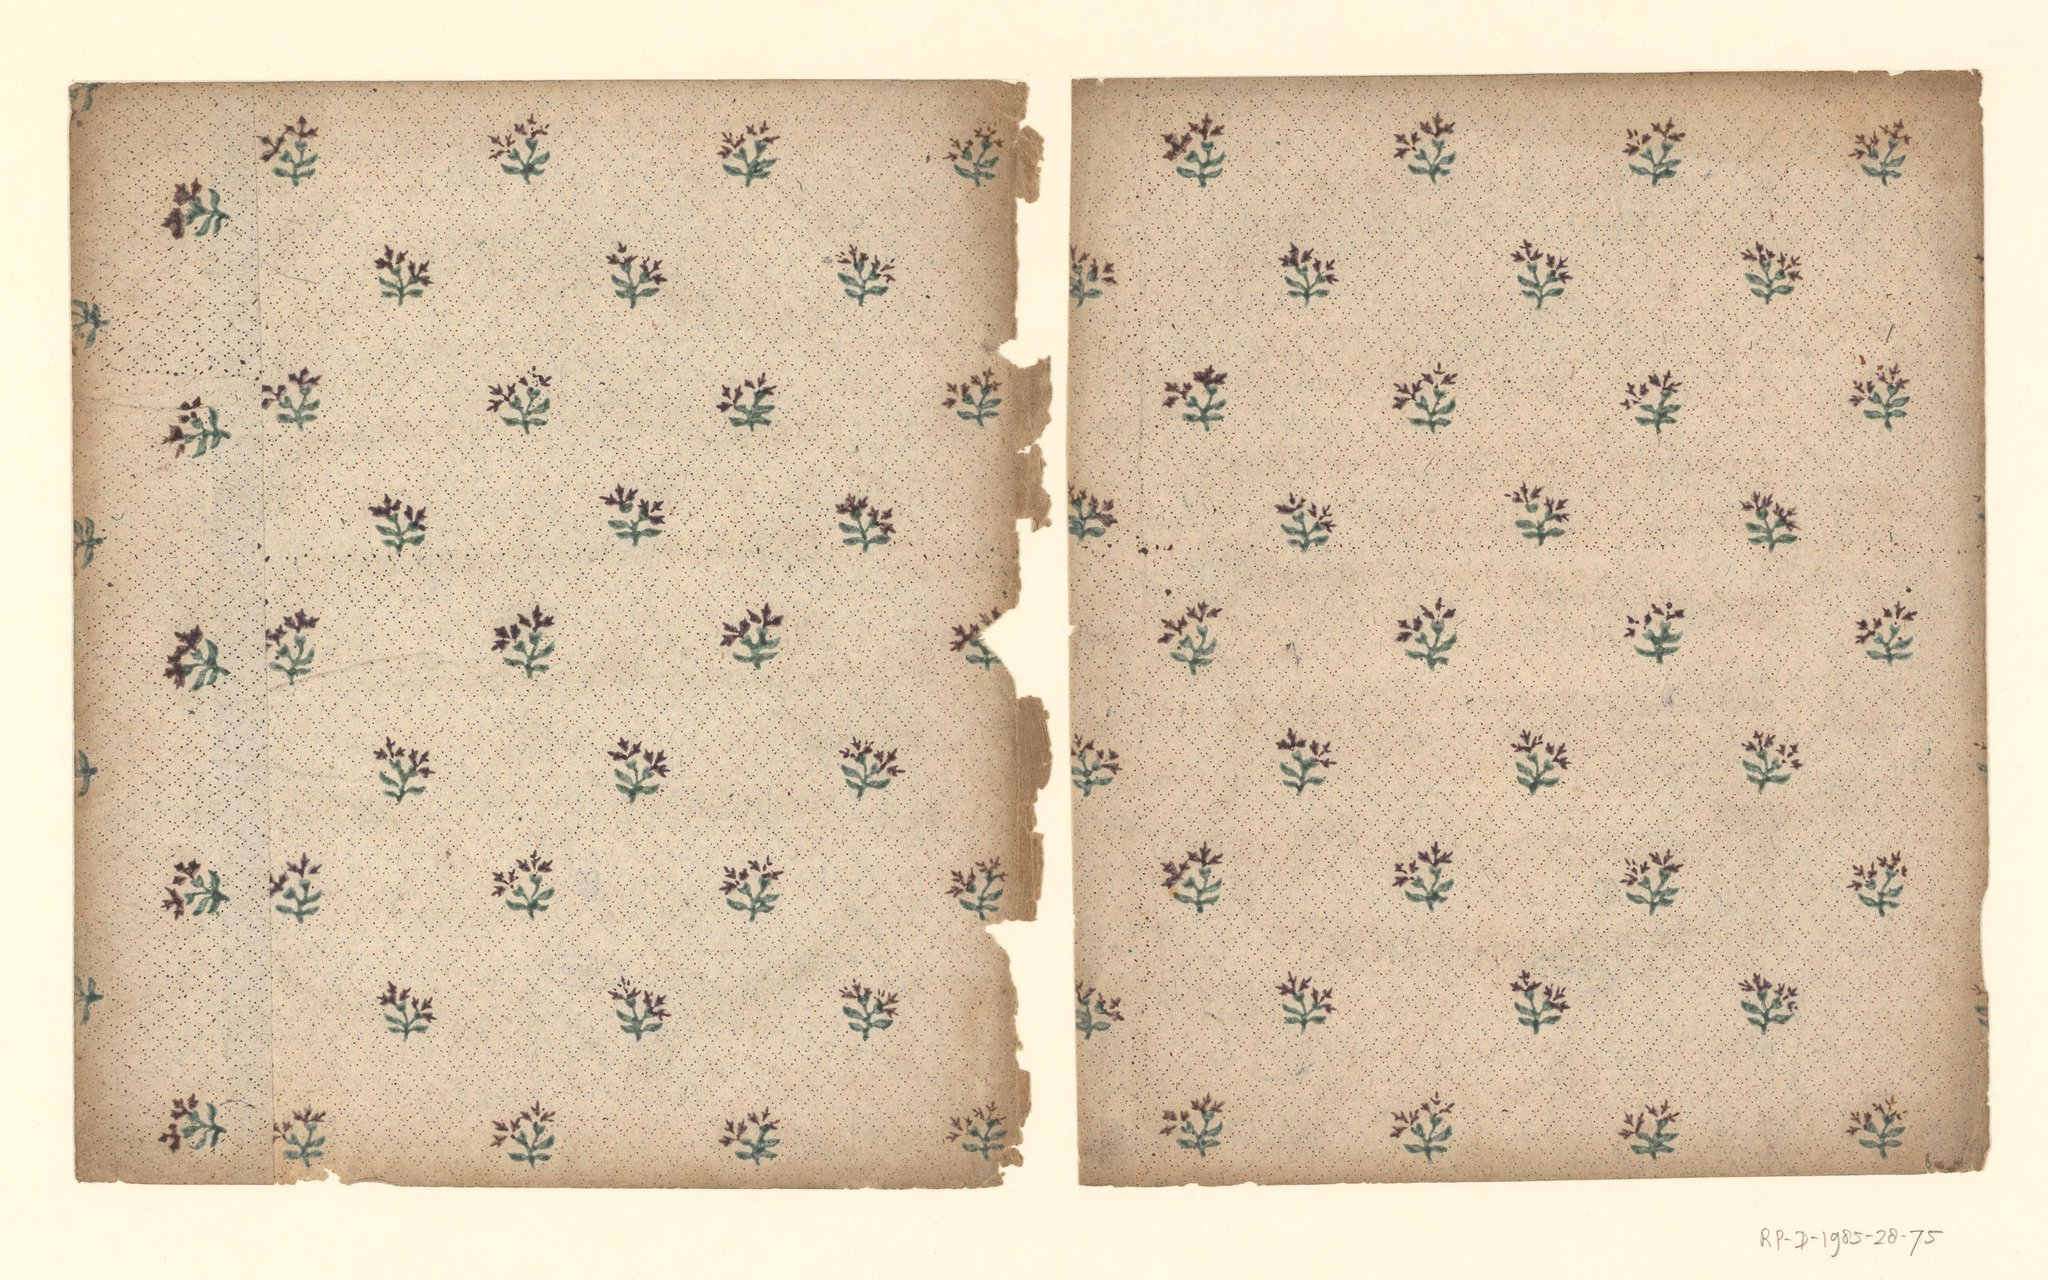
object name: printed paper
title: Twee bladen met strooipatroon van bloemtakje op puntenfond in ruiten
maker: Anonymous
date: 1750-1900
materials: paper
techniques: printing block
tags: ornament derived from plant forms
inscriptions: collector's mark: Lugt 2228, collector's mark: Lugt 2760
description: Twee bladen met strooipatroon van bloemtakje op puntenfond in ruiten. Twee losse helften van een omslag.